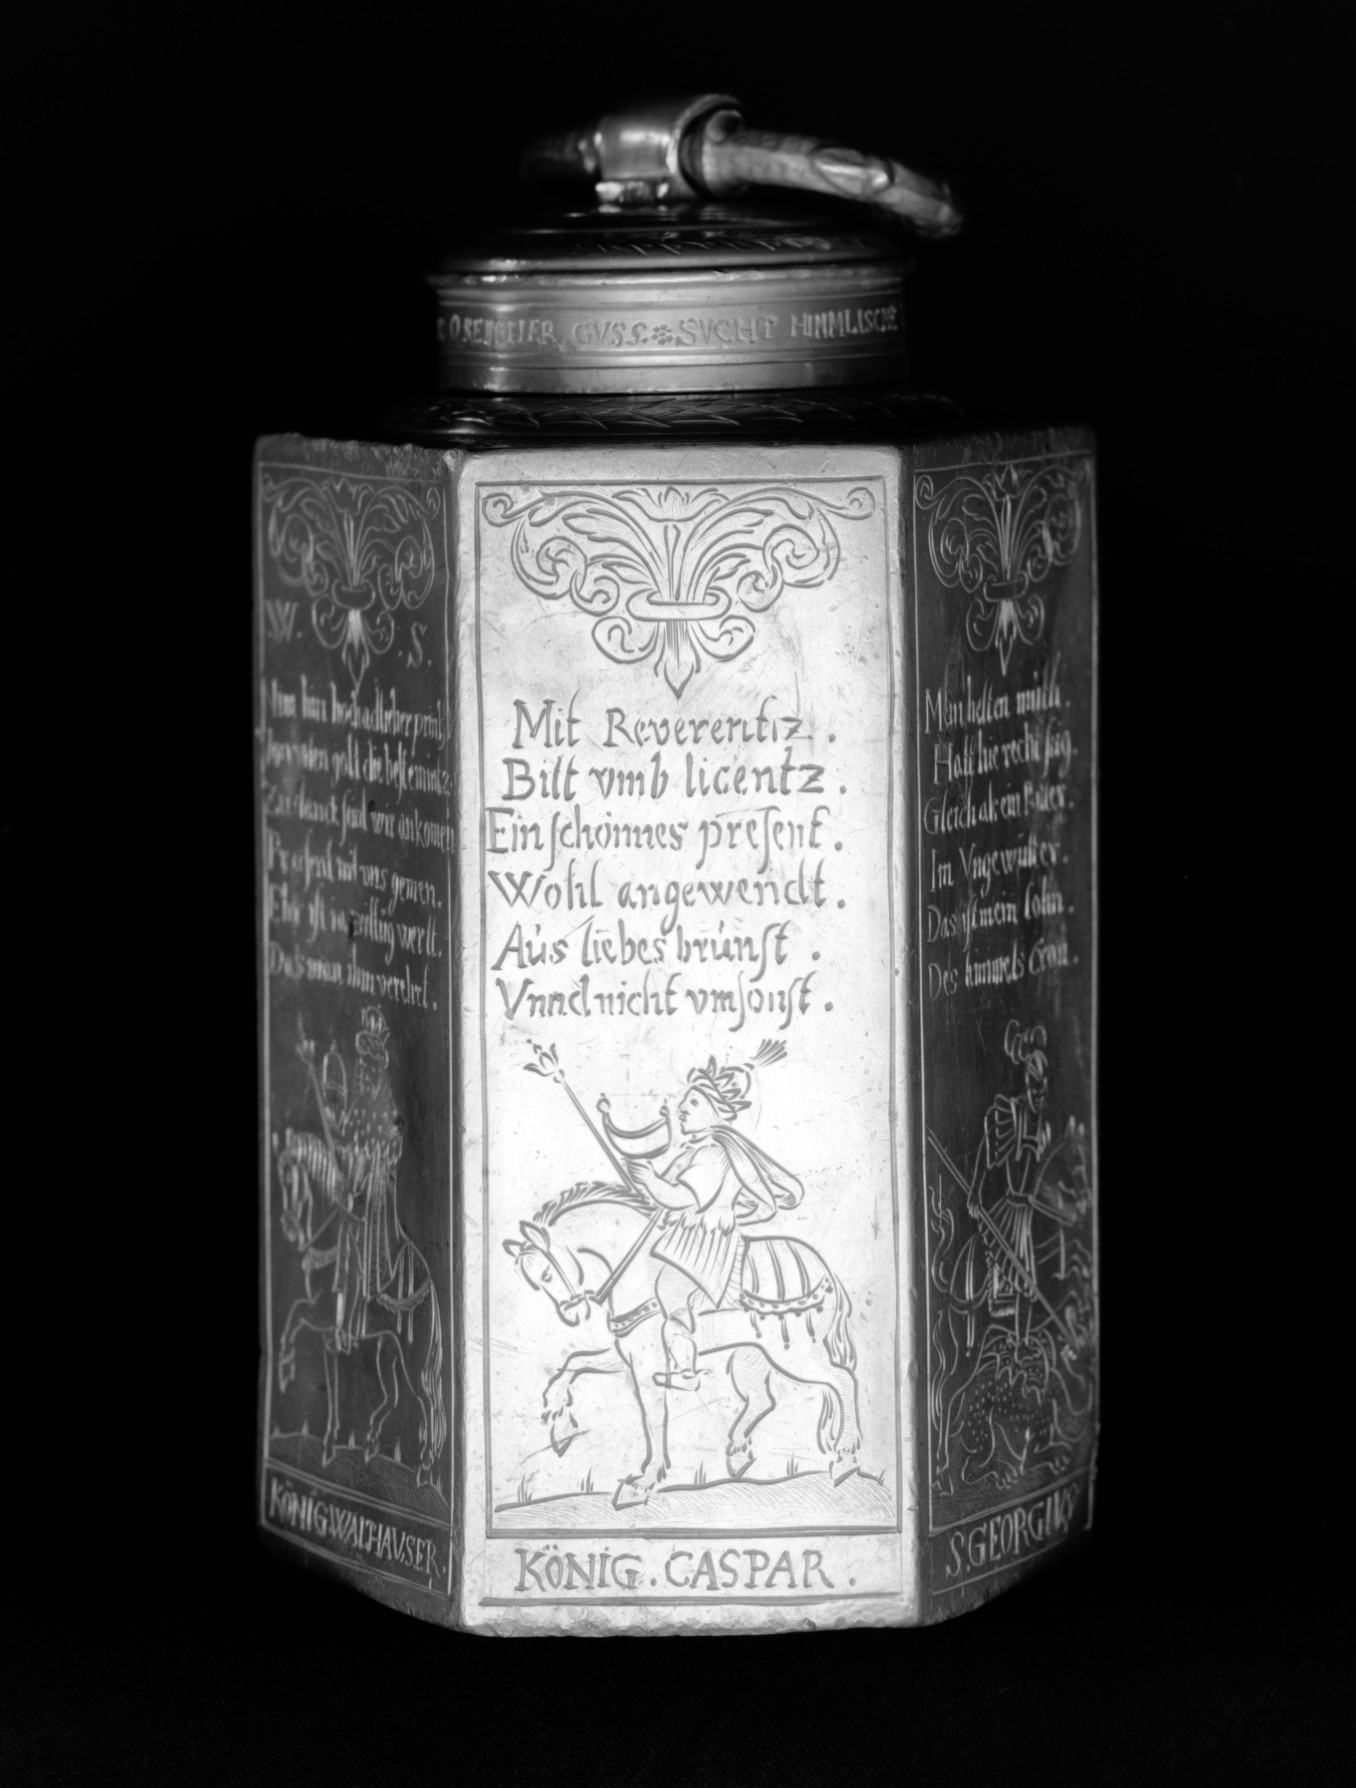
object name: wine can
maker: christoph stange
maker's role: maker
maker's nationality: german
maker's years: 1662-1717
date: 1667-1700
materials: pewter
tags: horses,jesus,crucifixion